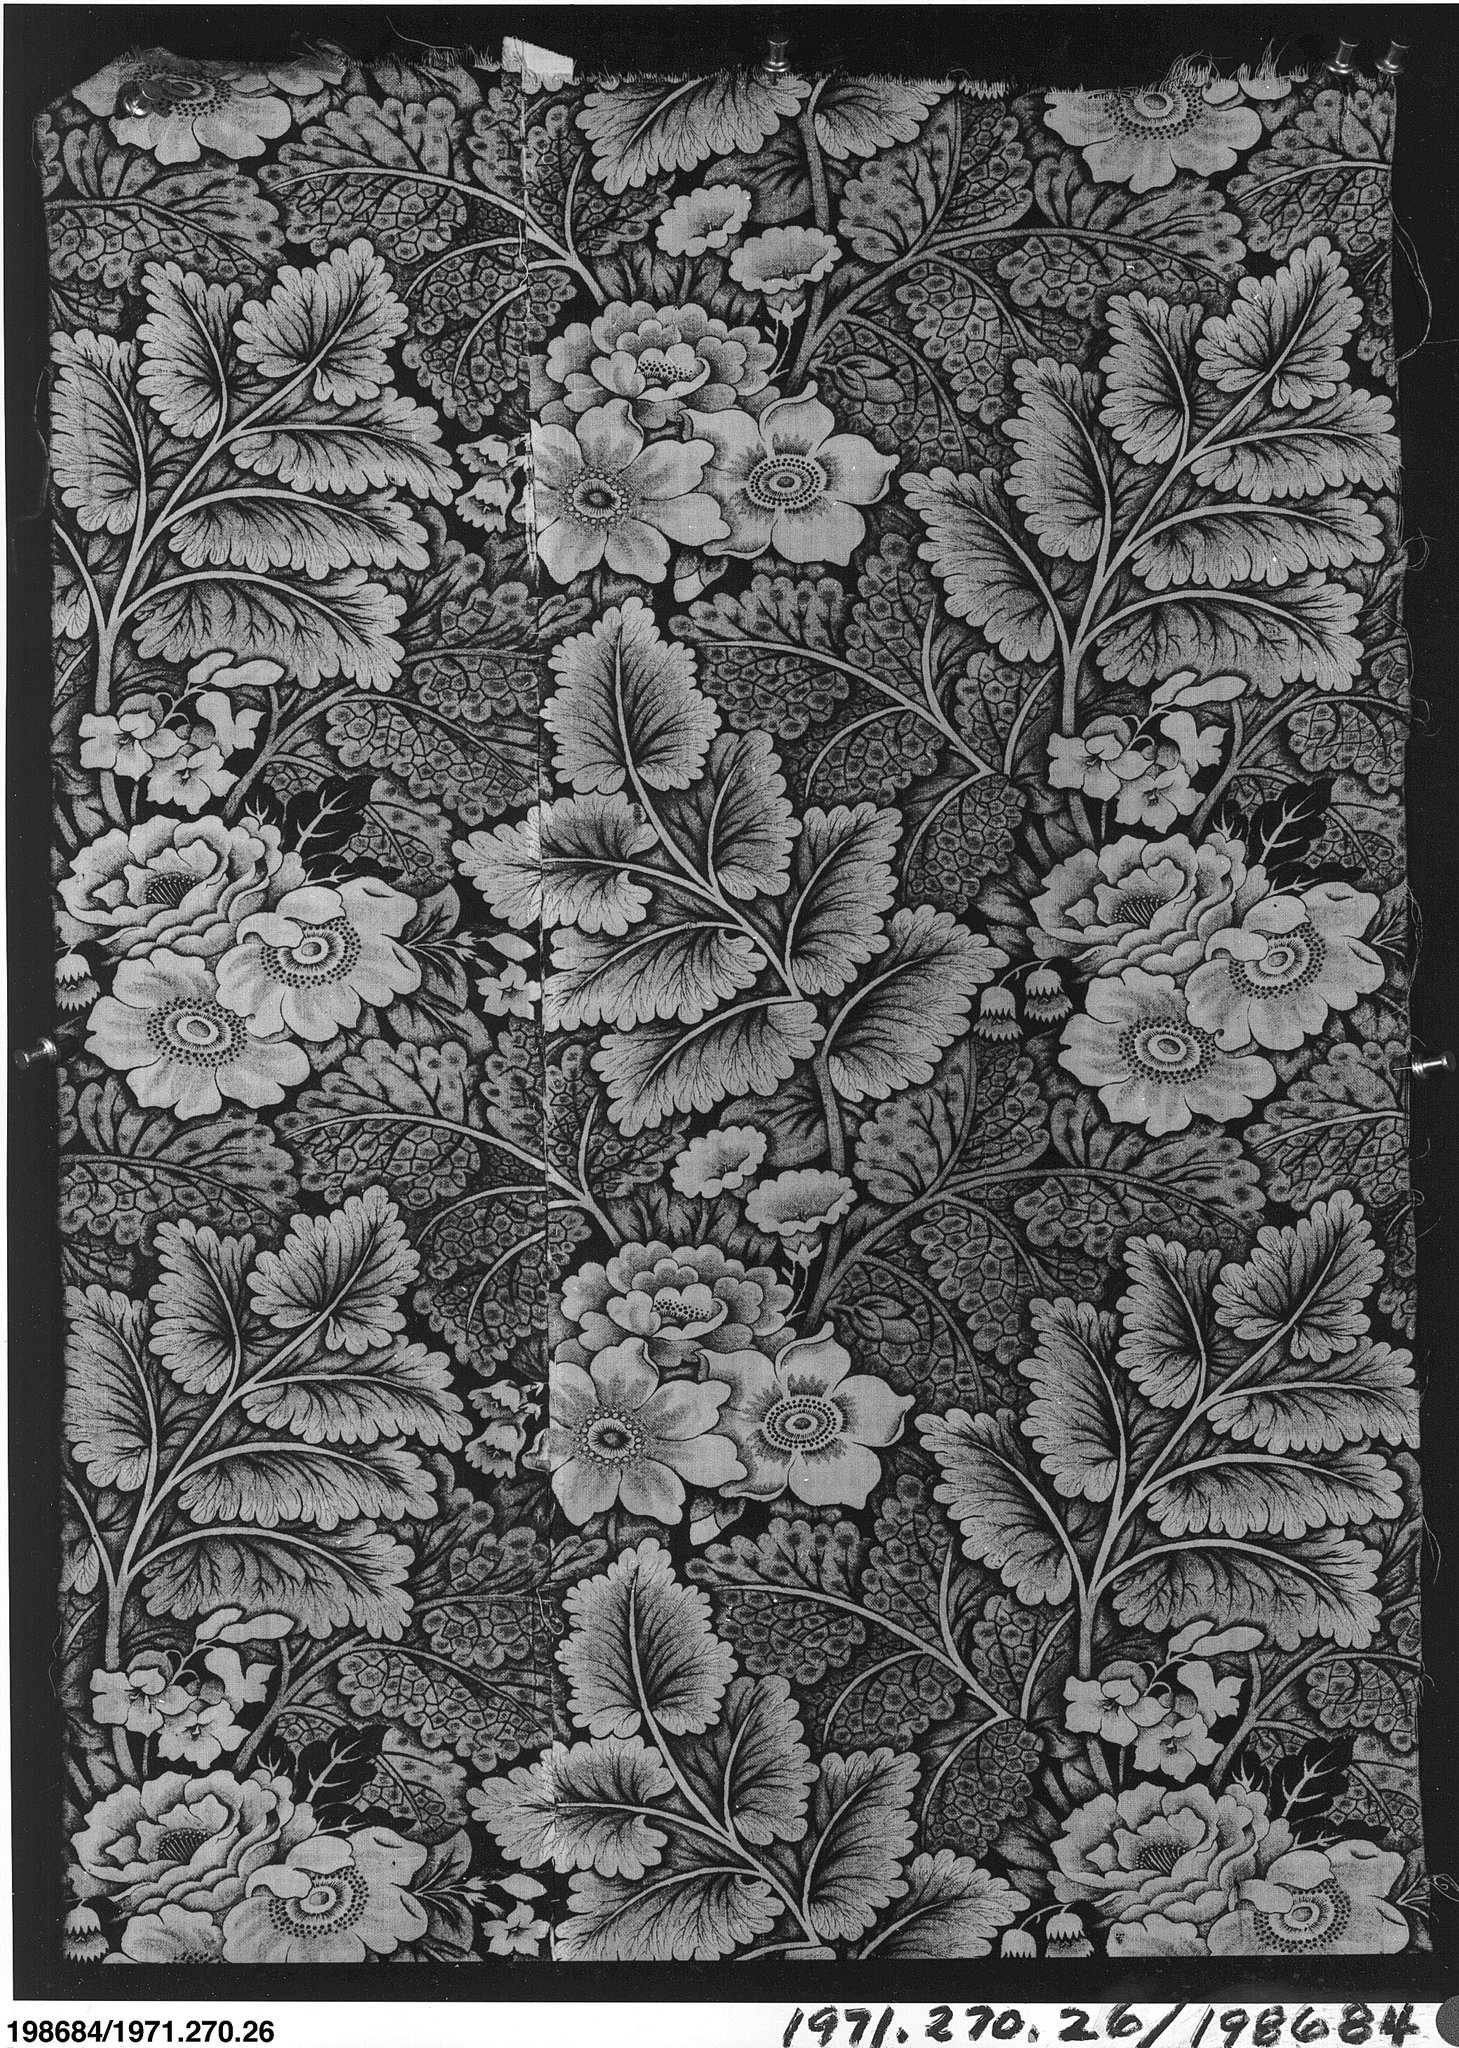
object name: piece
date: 1815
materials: cotton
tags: flowers,leaves